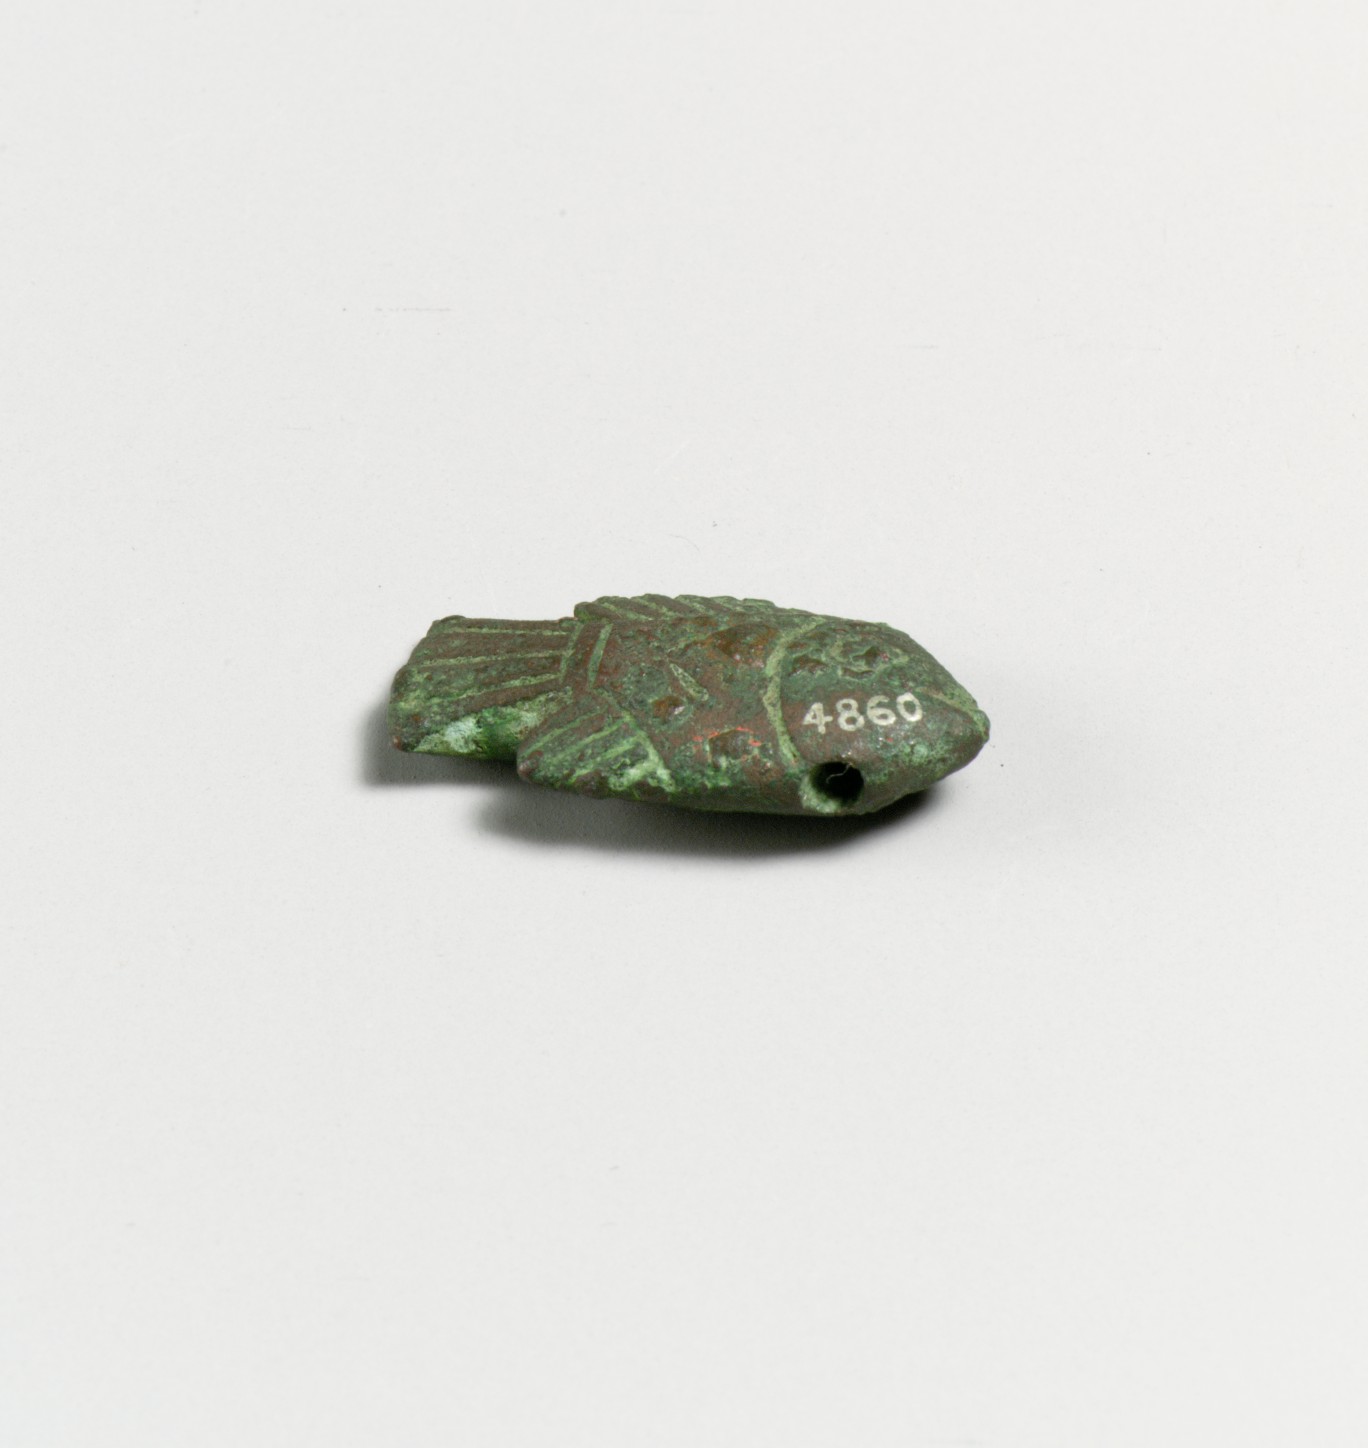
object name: pendant in the form of a fish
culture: cypriot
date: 3900 BCE-100 CE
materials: bronze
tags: fish